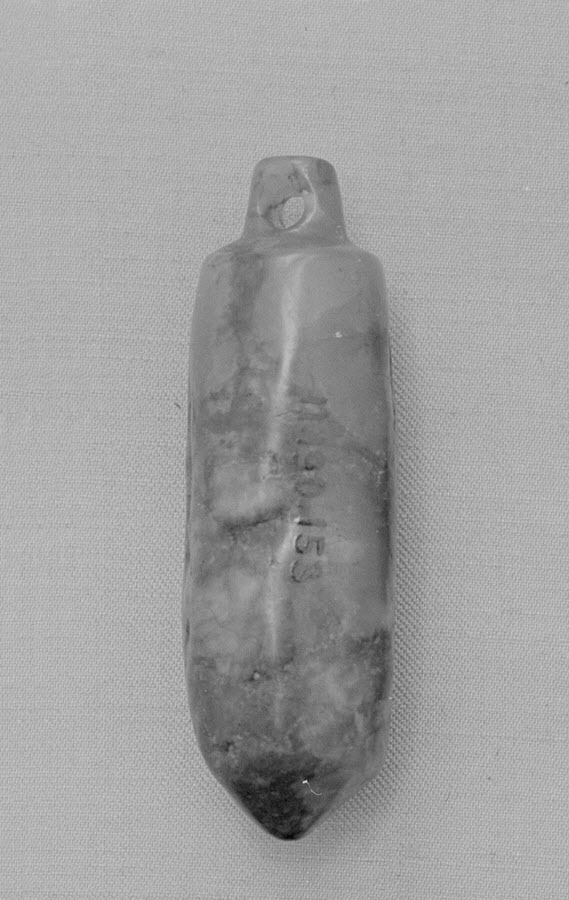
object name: pendant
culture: chinese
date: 3200-2000 BCE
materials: jade